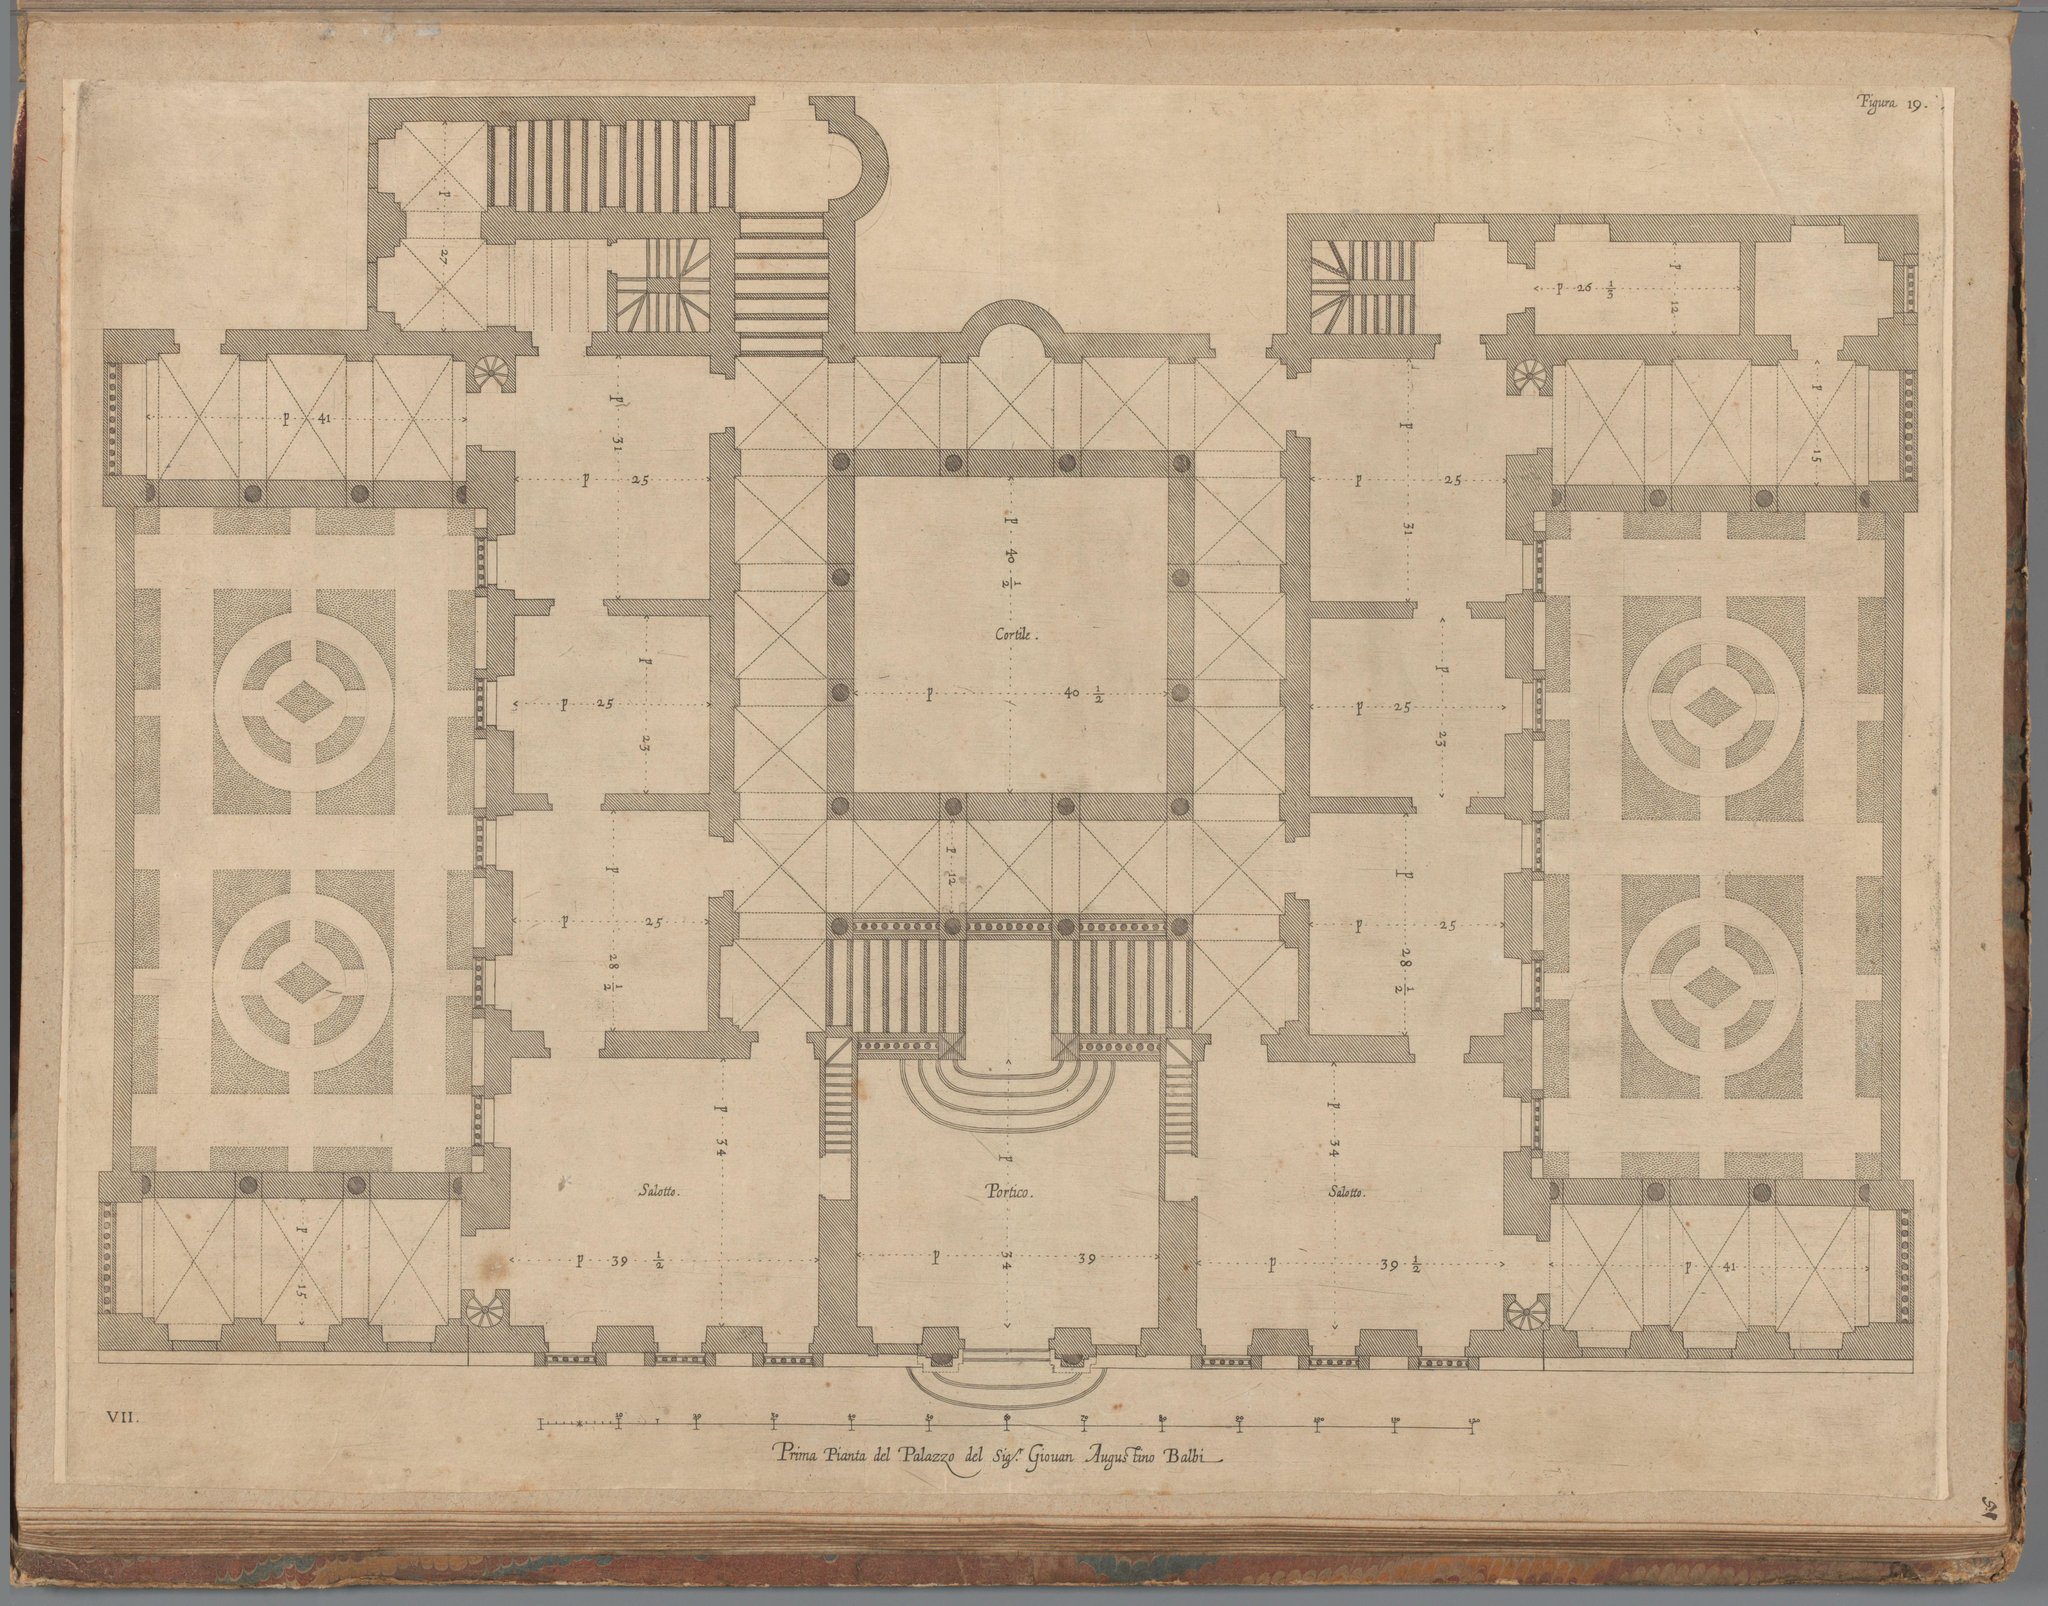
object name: print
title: Plattegrond van de begane grond van het Palazzo Durazzo-Pallavicini te Genua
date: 1622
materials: paper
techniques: engraving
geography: antwerp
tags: hôtel, i.e. small palace in city - aa - civic architecture: inside, plan ~ architecture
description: Deze prent maakt deel uit van een album.